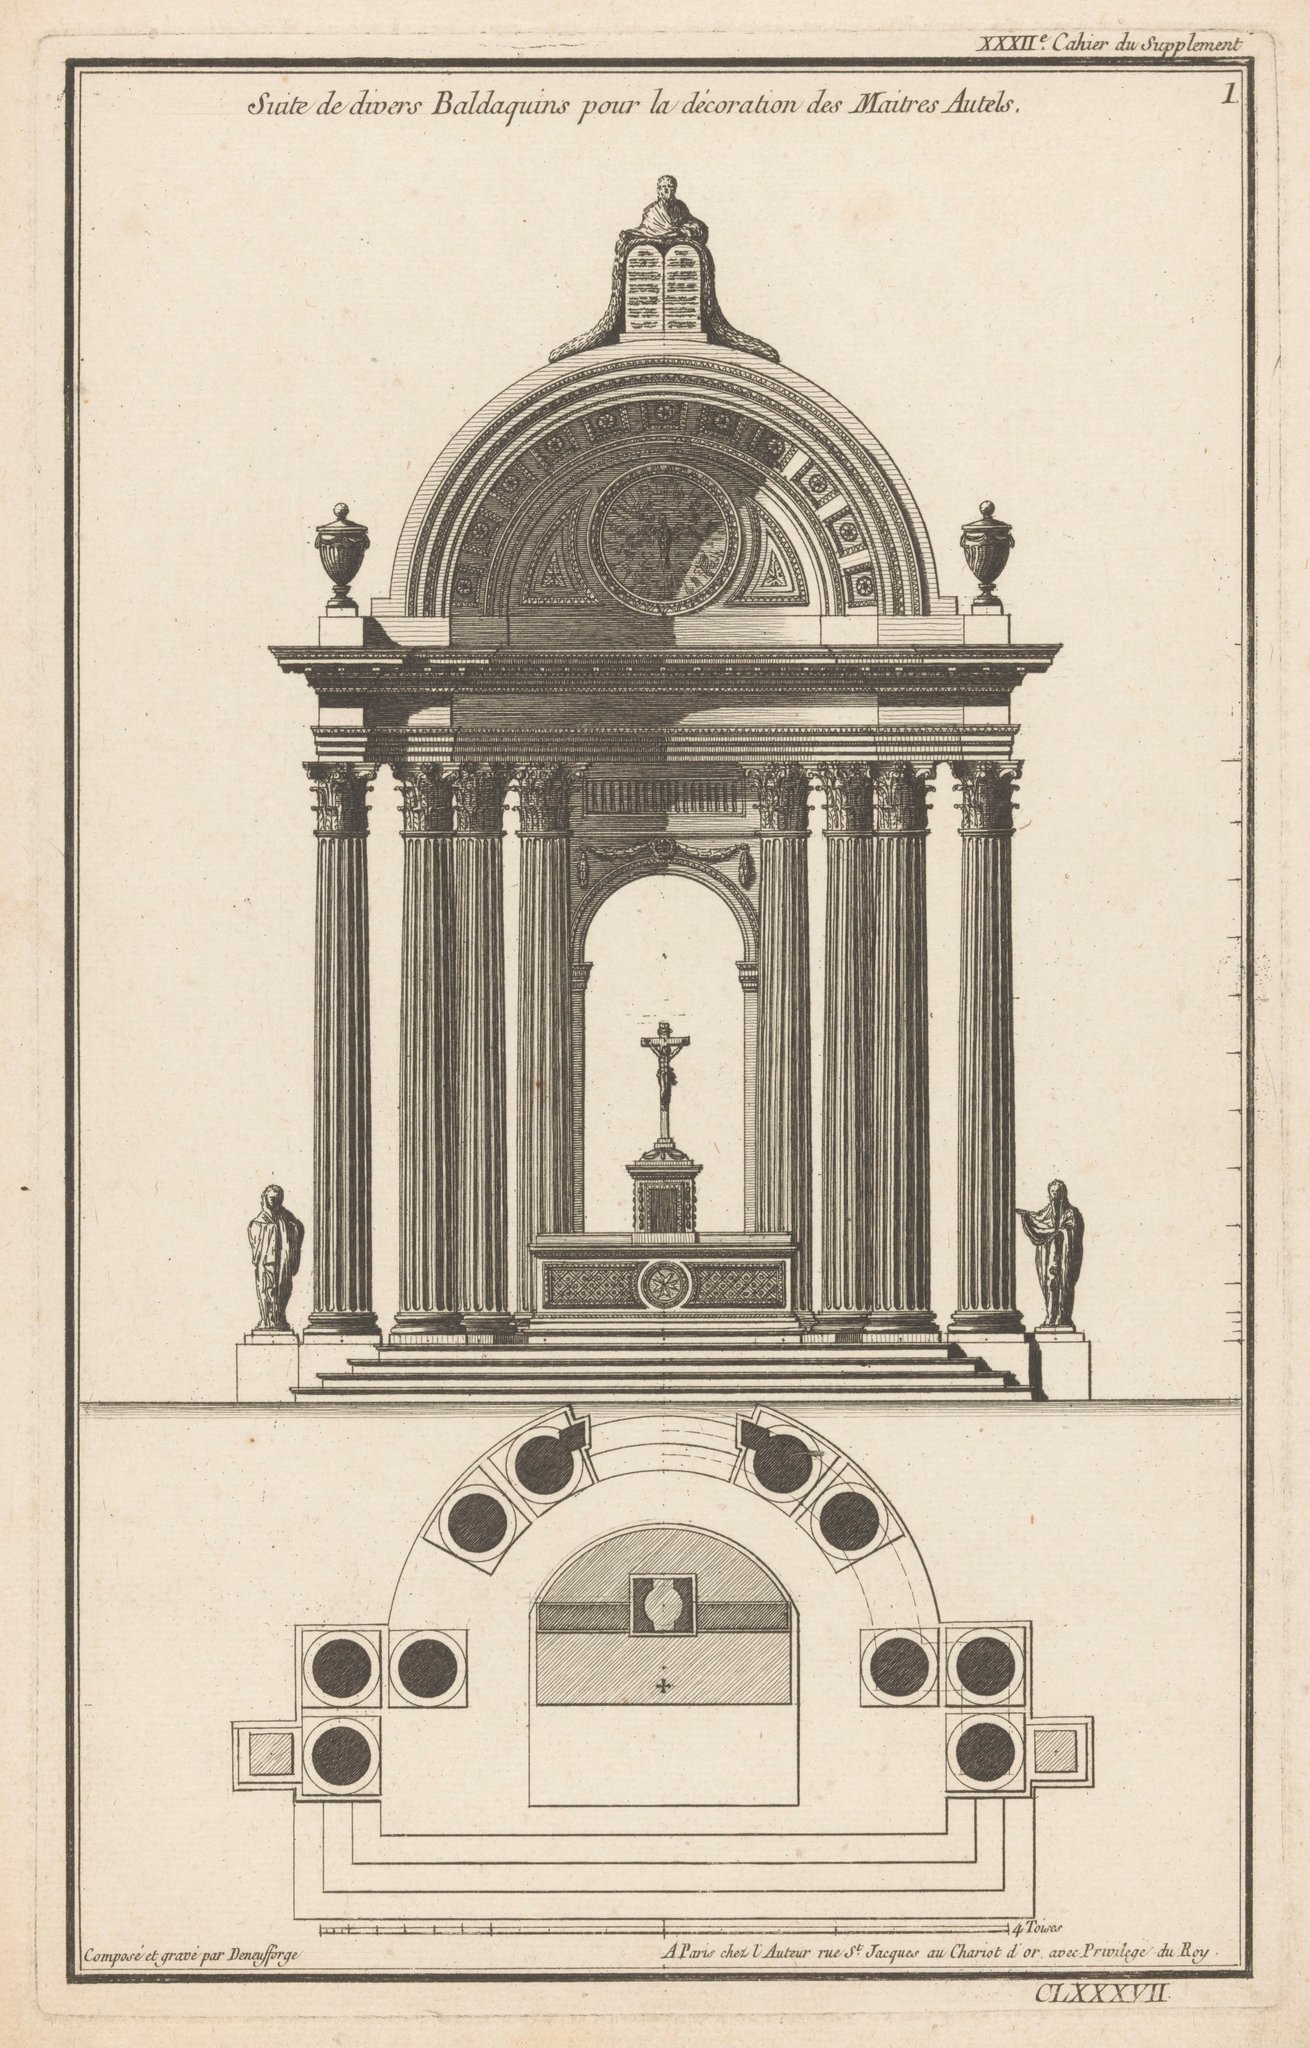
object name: print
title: Baldakijn met kruis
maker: jean françois de neufforge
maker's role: print maker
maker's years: 1714-1791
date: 1772-1780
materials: paper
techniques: etching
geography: paris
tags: canopy, baldachin, altarcross, crucifix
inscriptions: collector's mark: Lugt 2228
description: Vooraanzicht en plattegrond van een baldakijn met een medaillon met de duif als symbool van de Heilige Geest. Onder het baldakijn staat in het midden een altaar met een kruisbeeld en links en rechts twee beelden. Bovenop het baldakijn staan twee vazen en Mozes met de stenen tafelen. Prentnummer CLXXXVII.